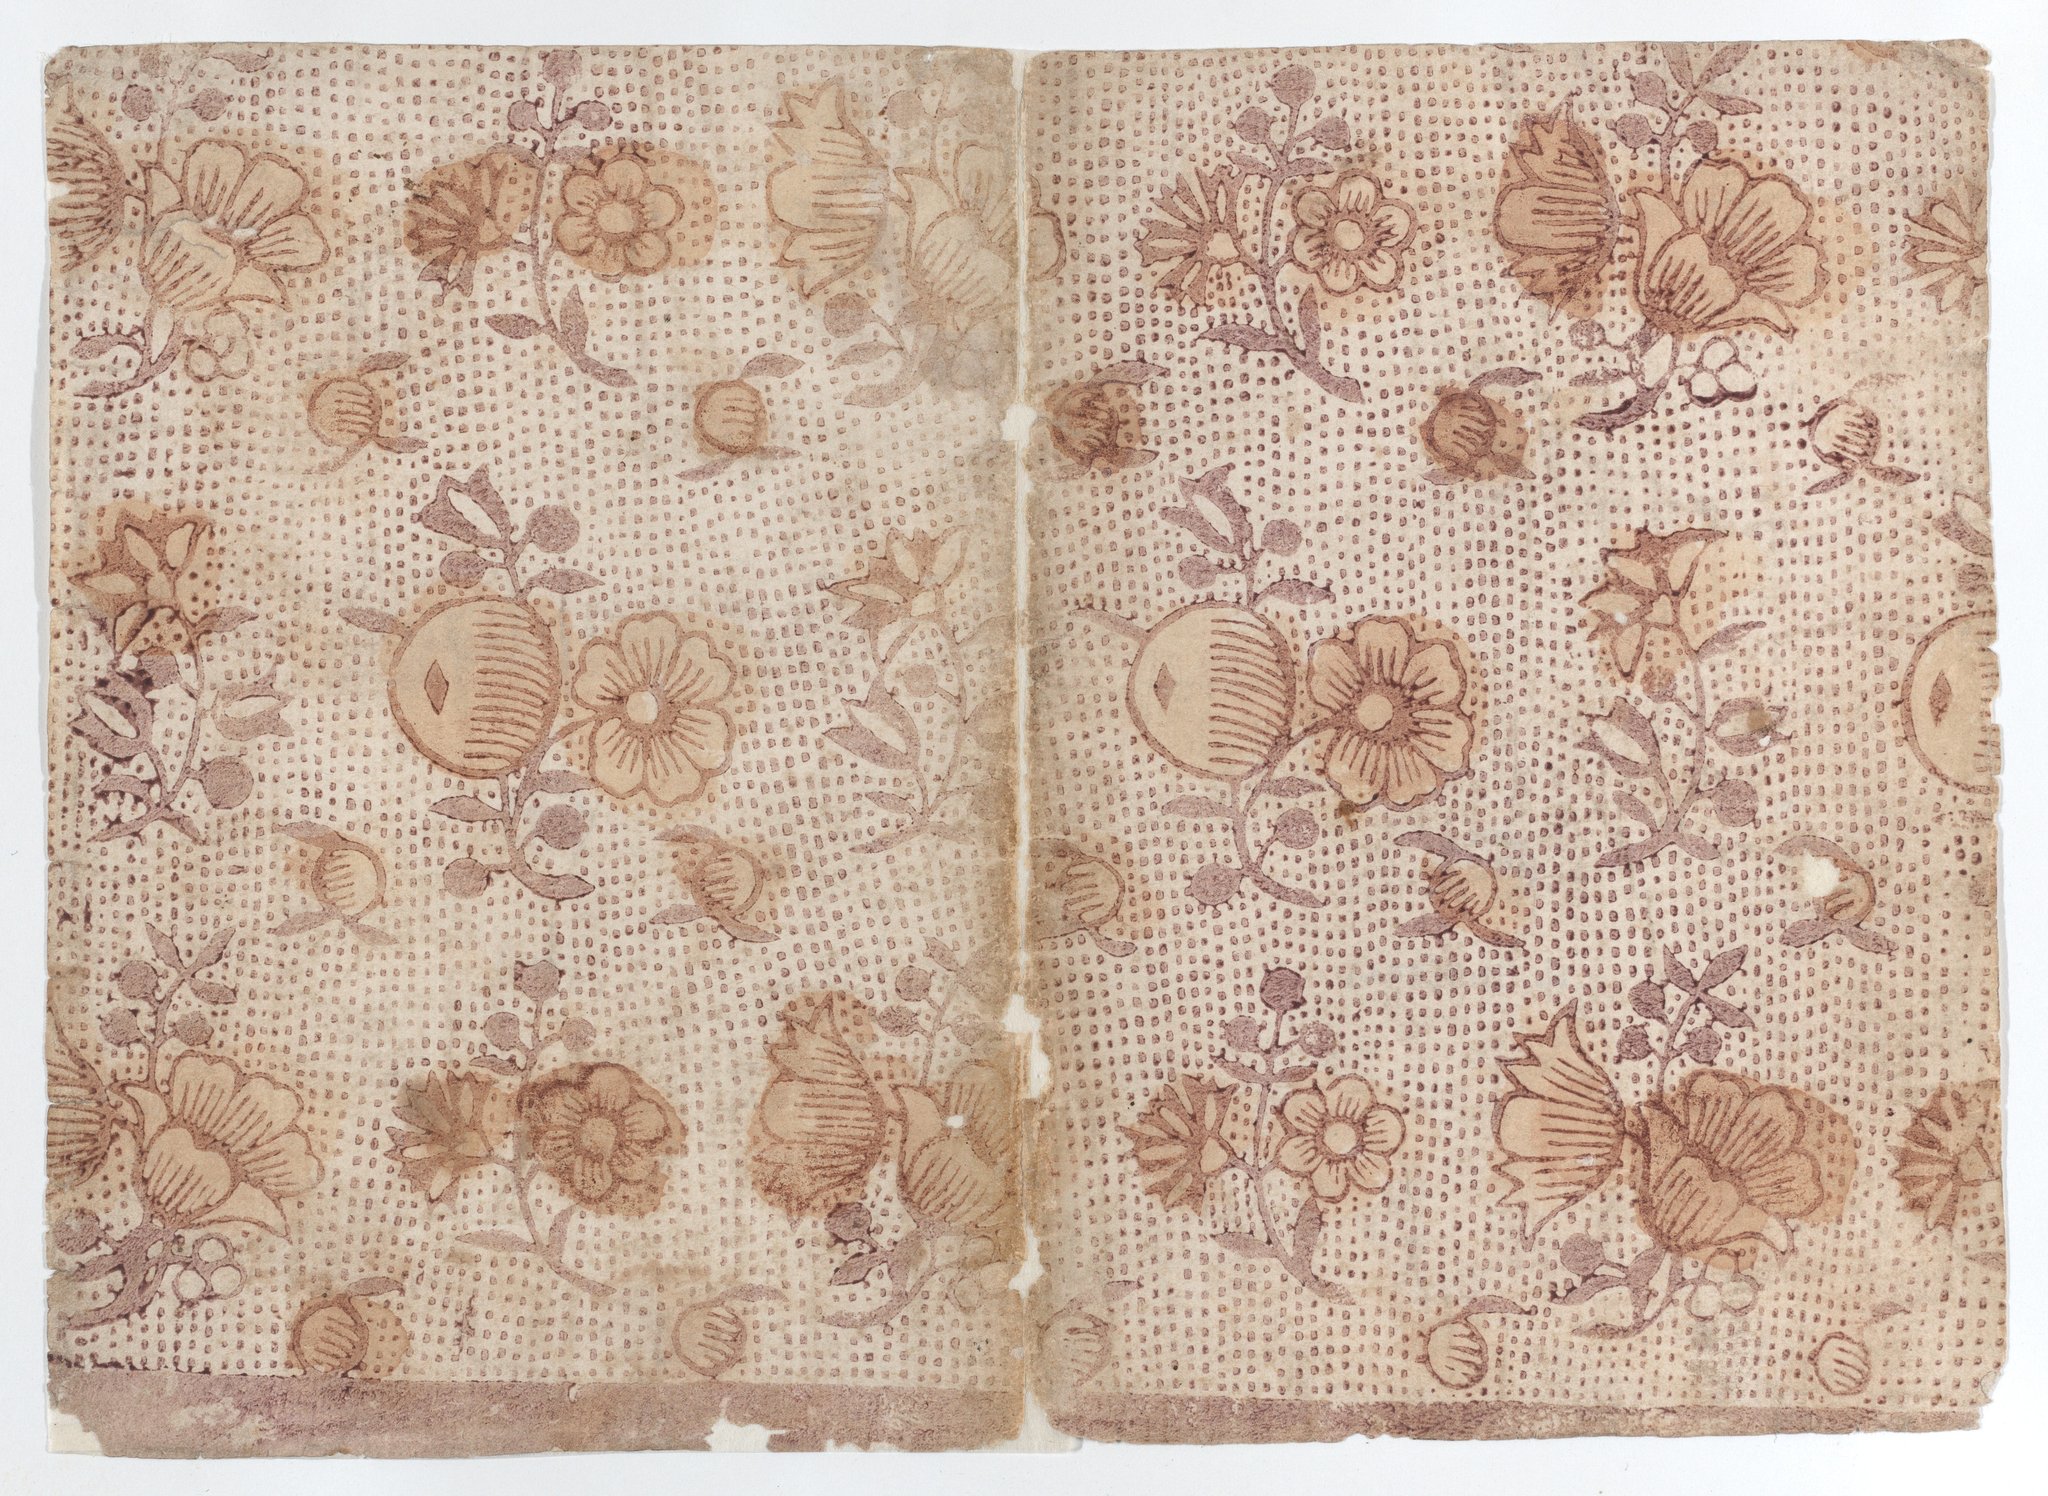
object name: print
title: Book cover with overall floral and dot pattern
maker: Anonymous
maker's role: artist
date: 1701-1800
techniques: relief print